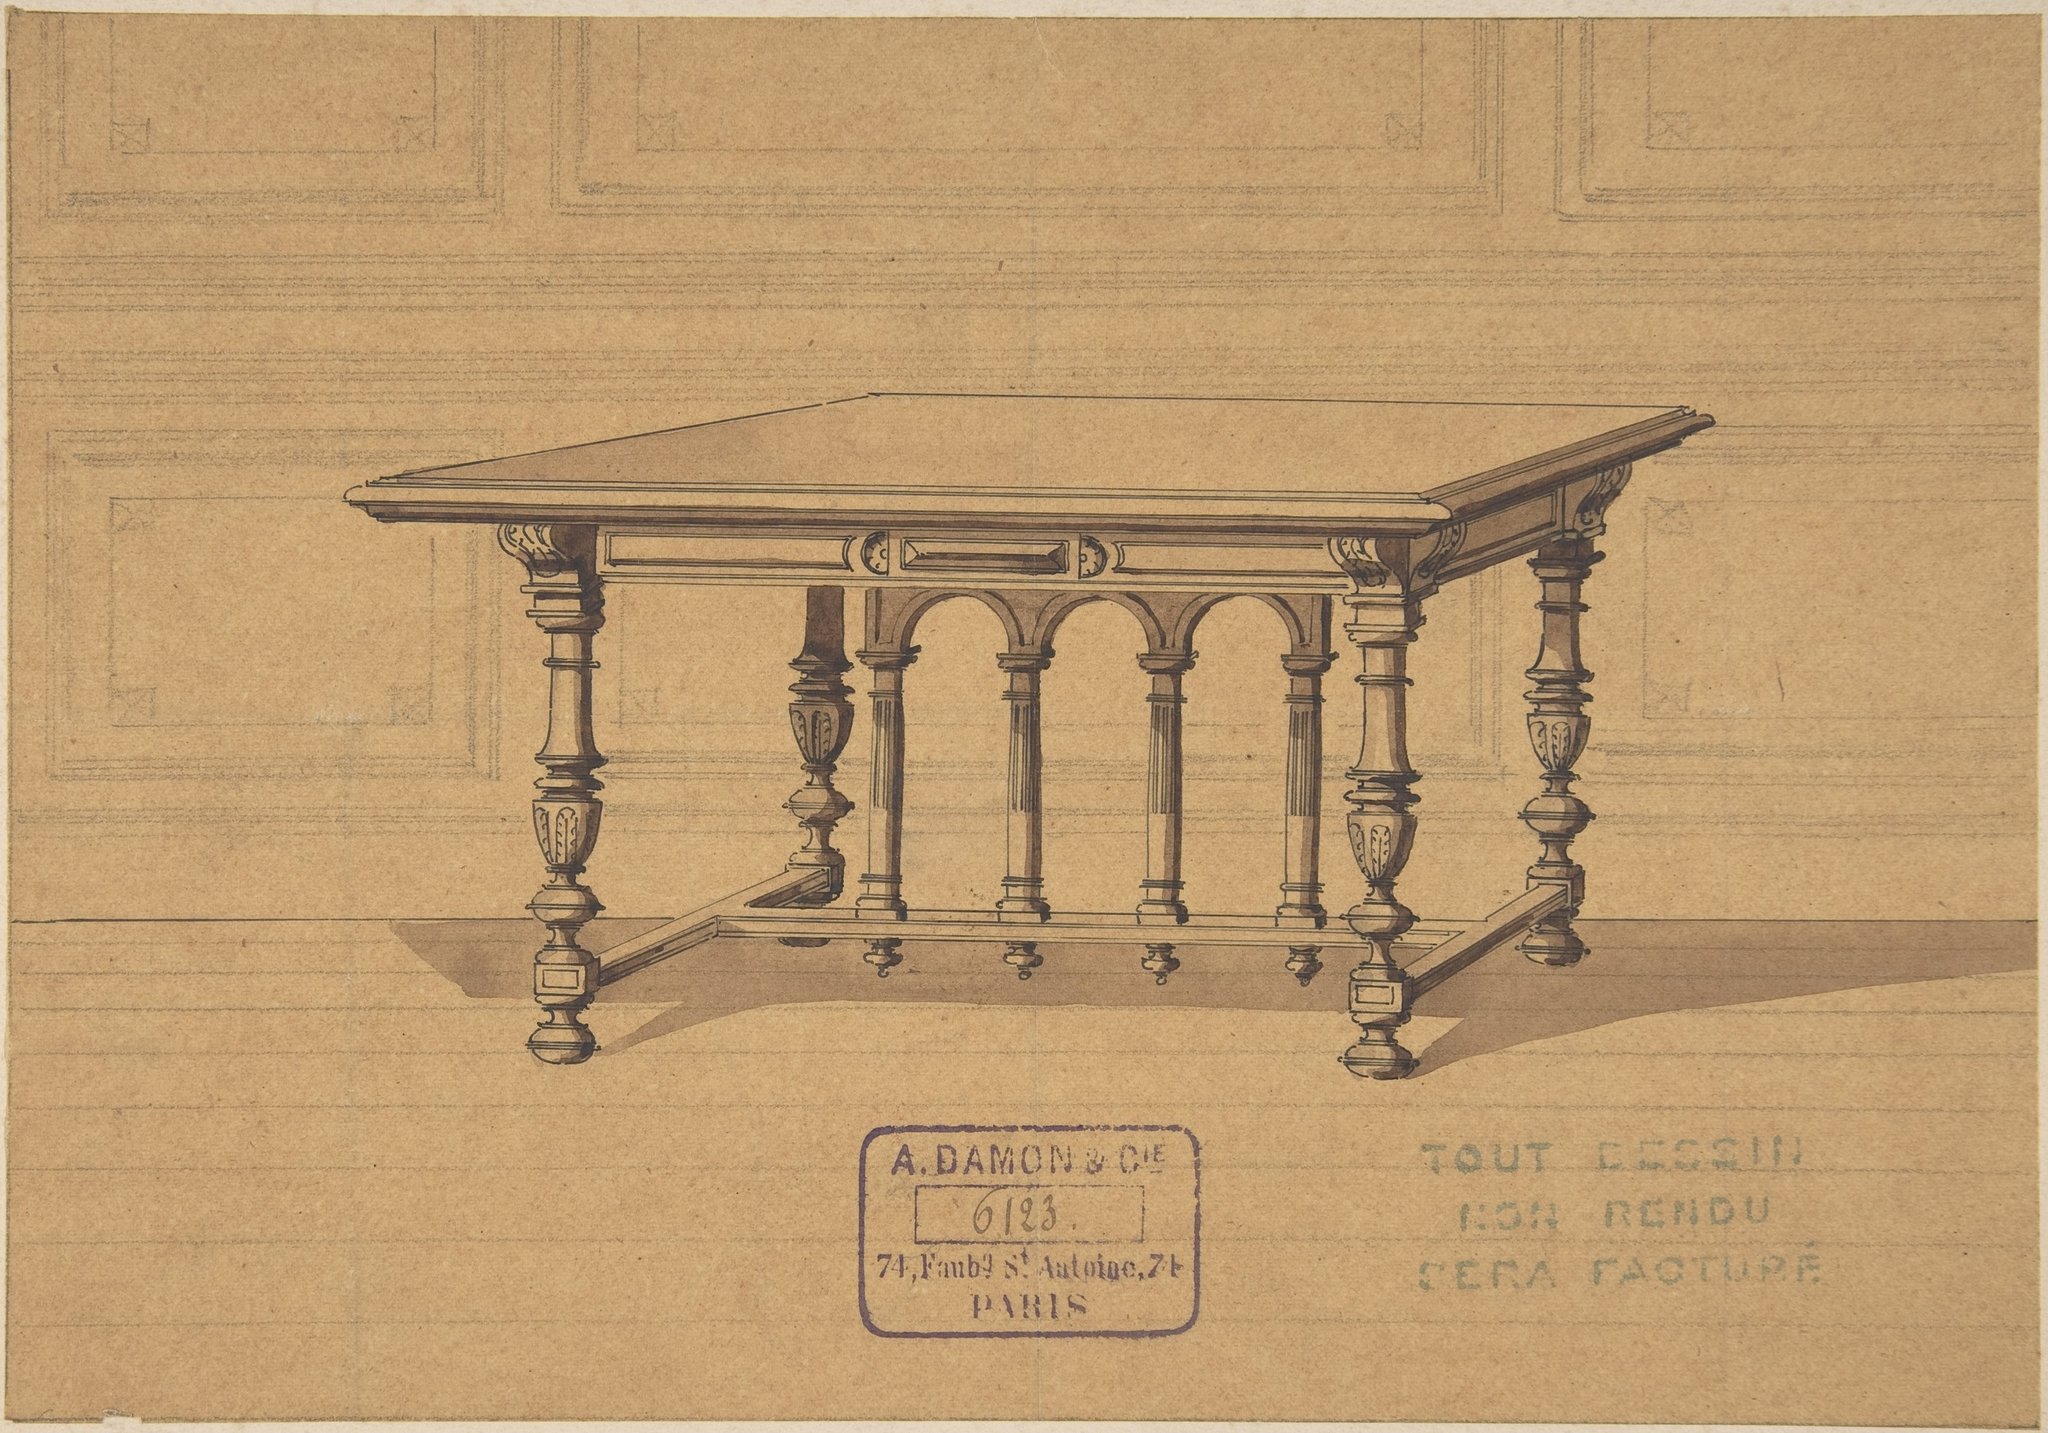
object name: drawing ornament architecture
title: Design for a Table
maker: a. damon et cie.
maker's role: artist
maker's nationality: french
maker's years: 1870-1900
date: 1870-1880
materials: graphite, ink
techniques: brush, pen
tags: tables